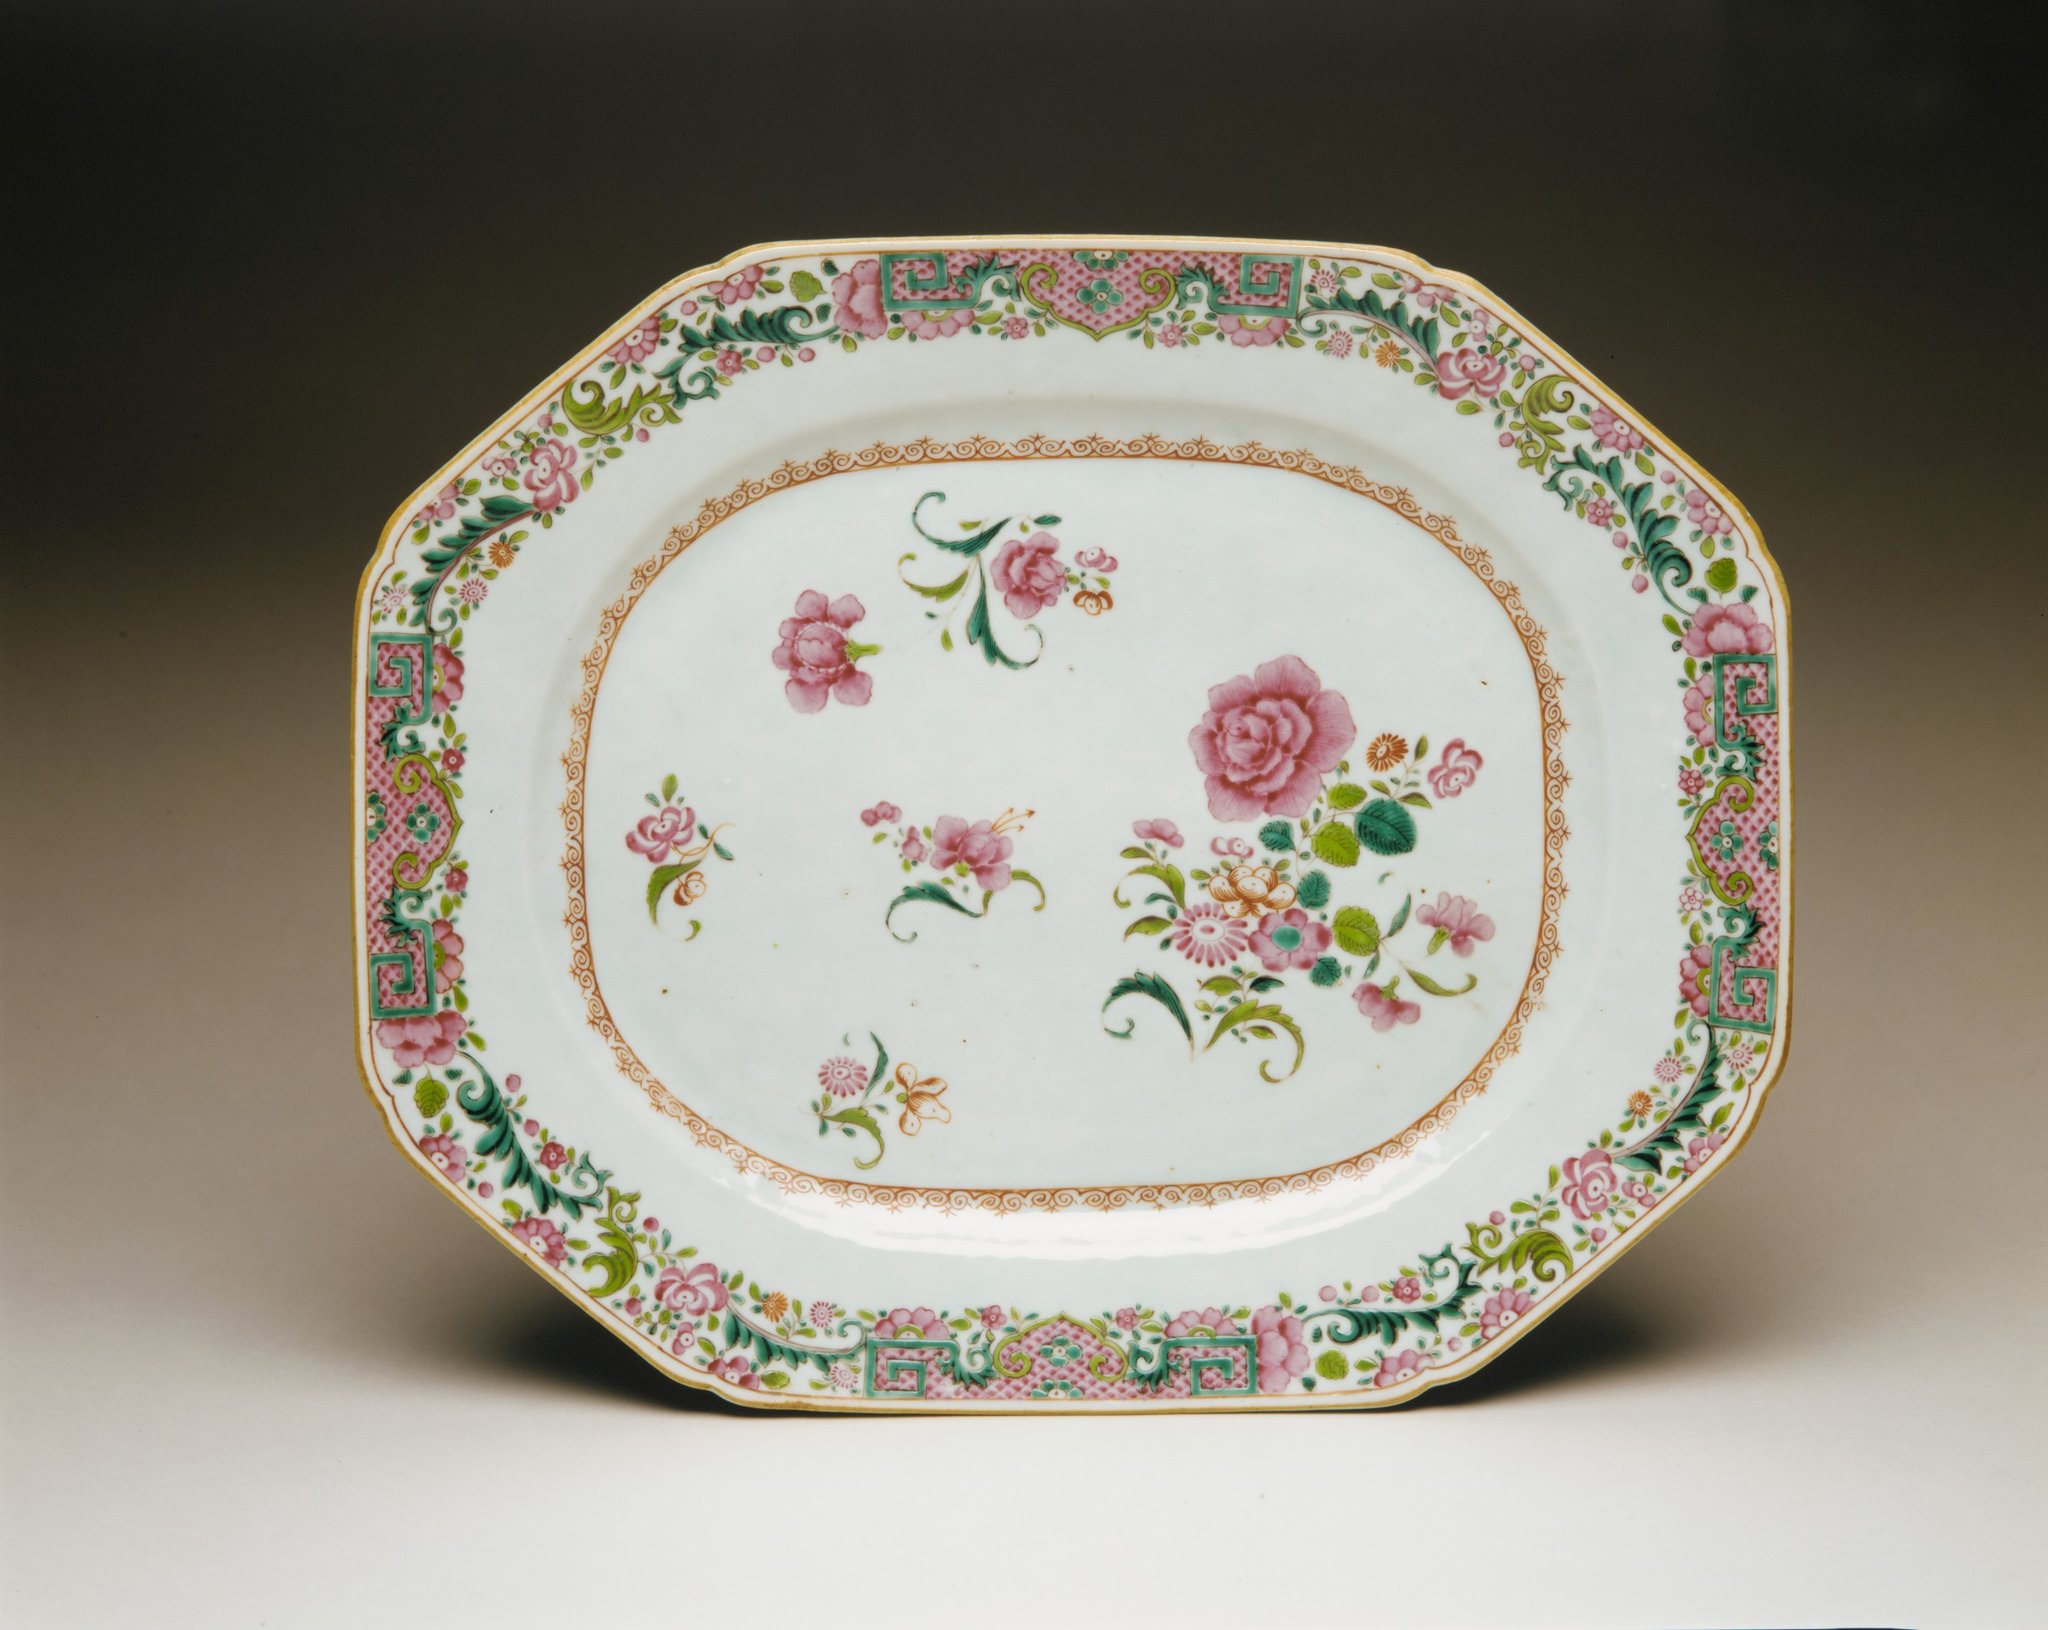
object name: platter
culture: chinese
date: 1736-1795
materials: porcelain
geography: china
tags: flowers